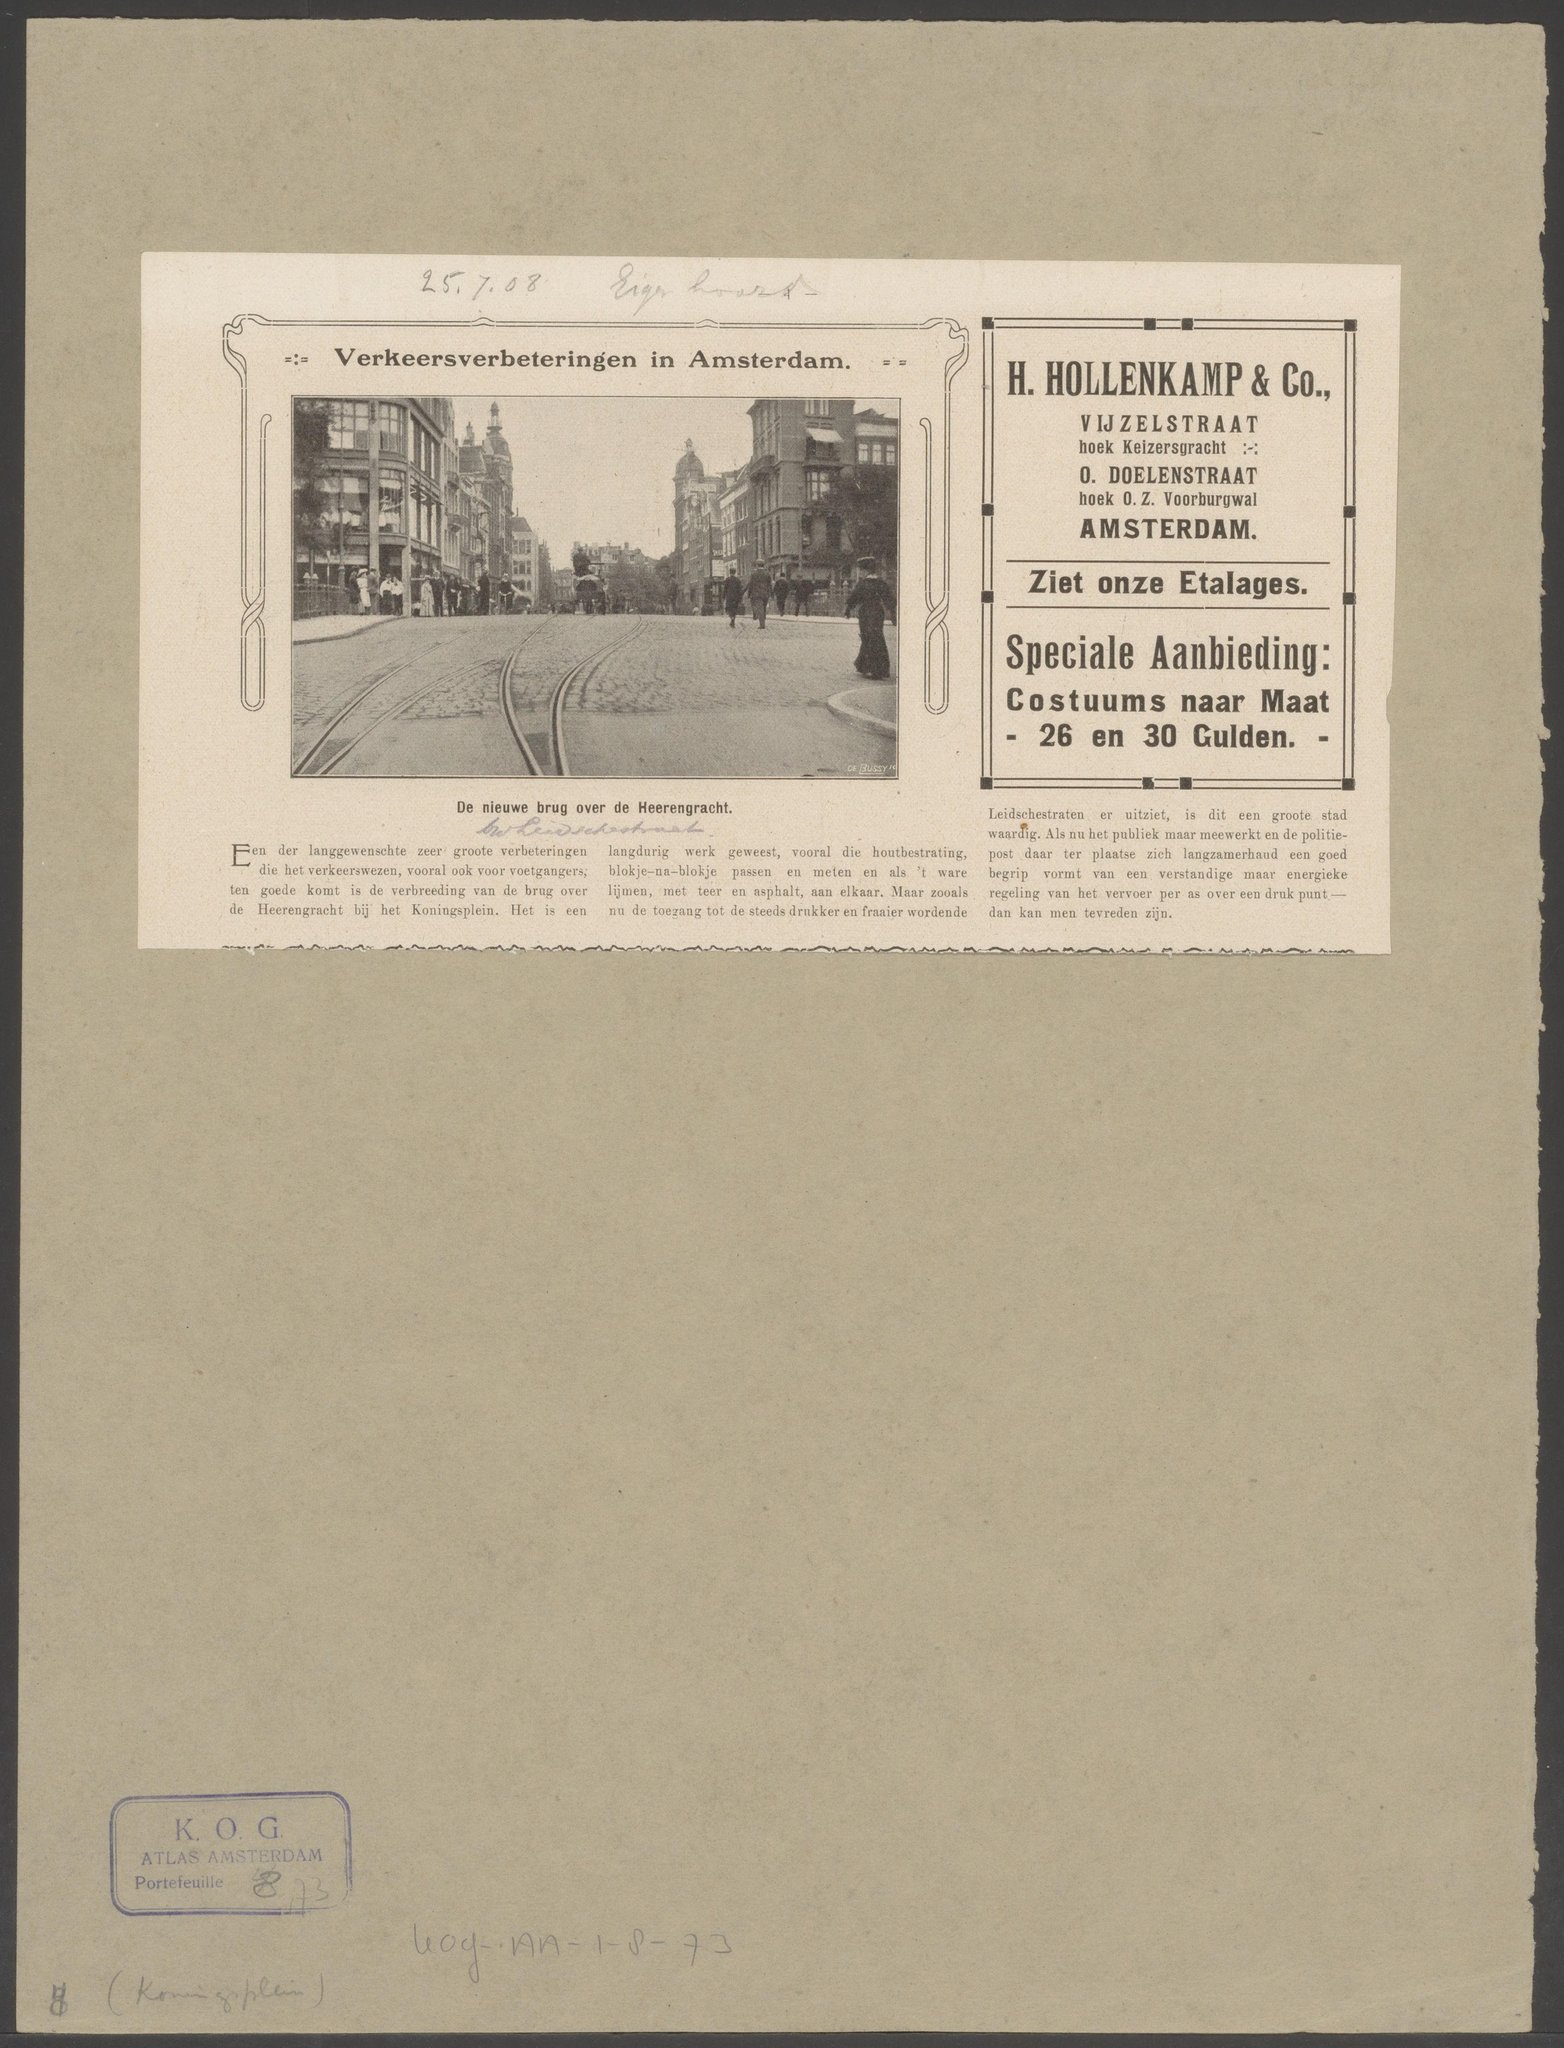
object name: photomechanical print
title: Gezicht op de Herengracht bij de Leidsestraat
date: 1908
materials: paper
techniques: letterpress printing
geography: haarlem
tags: tramway, tram, city-view in general; 'veduta', street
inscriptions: collector's mark: ‘8,73’ Lugt 1641b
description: Onderwerpsrubriek binnen de Atlas Amsterdam: Haarlemmerplein, Halvemaansteeg, Handboogstraat, Handelskade, Haringpakkerij, Hartenstraat, Hasseltsteeg (Dirk van), Heerengracht.